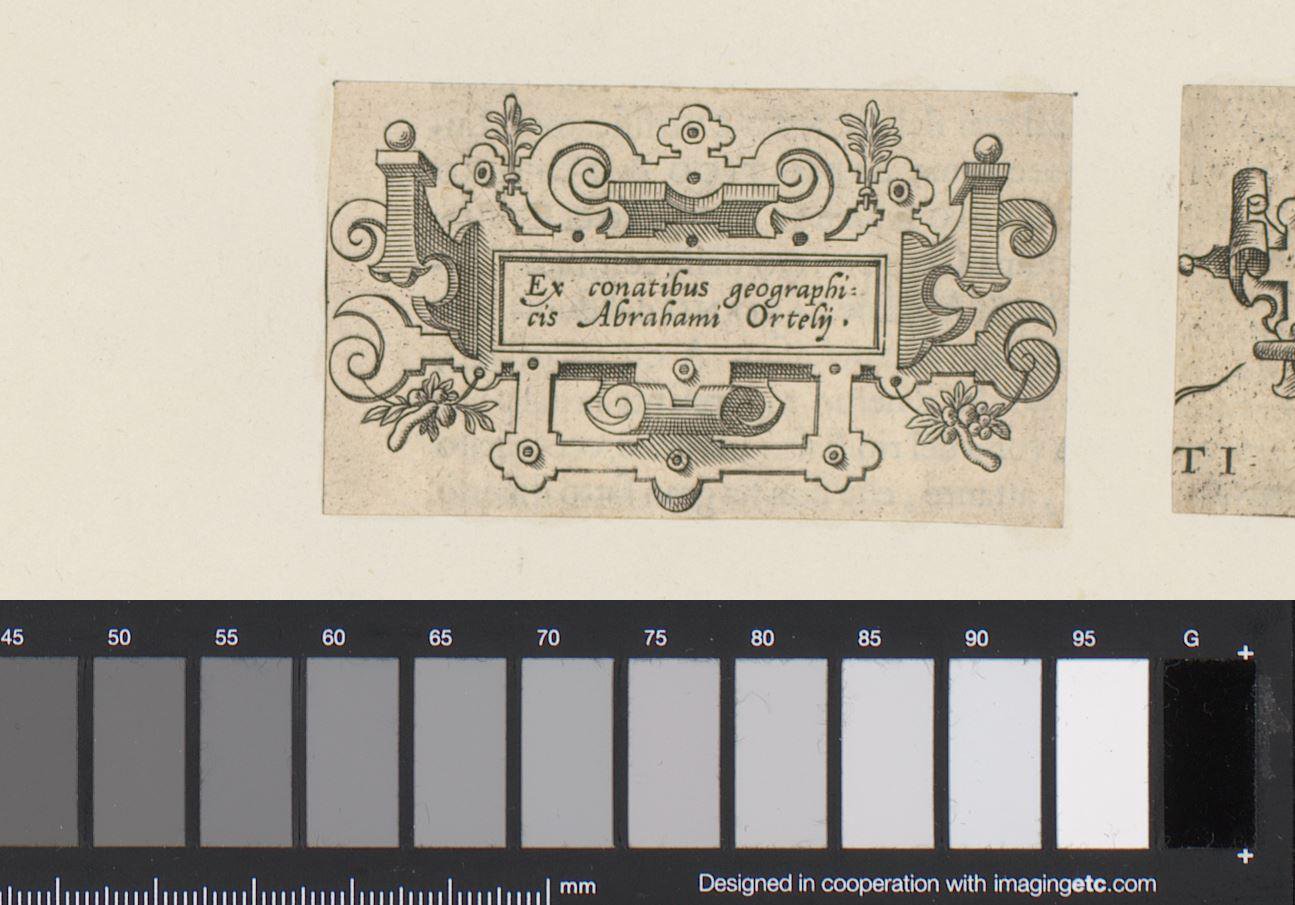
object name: print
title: Kleine cartouche met trossen fruit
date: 1590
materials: paper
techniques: engraving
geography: antwerp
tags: fruits and vegetables ~ ornament, scrollwork, strapwork ~ ornament, ornament ~ cartouche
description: Kleine rolwerkcartouche met trossen fruit. De cartouche is een fragment van een kaart van de Zwarte Zee. De prent maakt deel uit van een album.